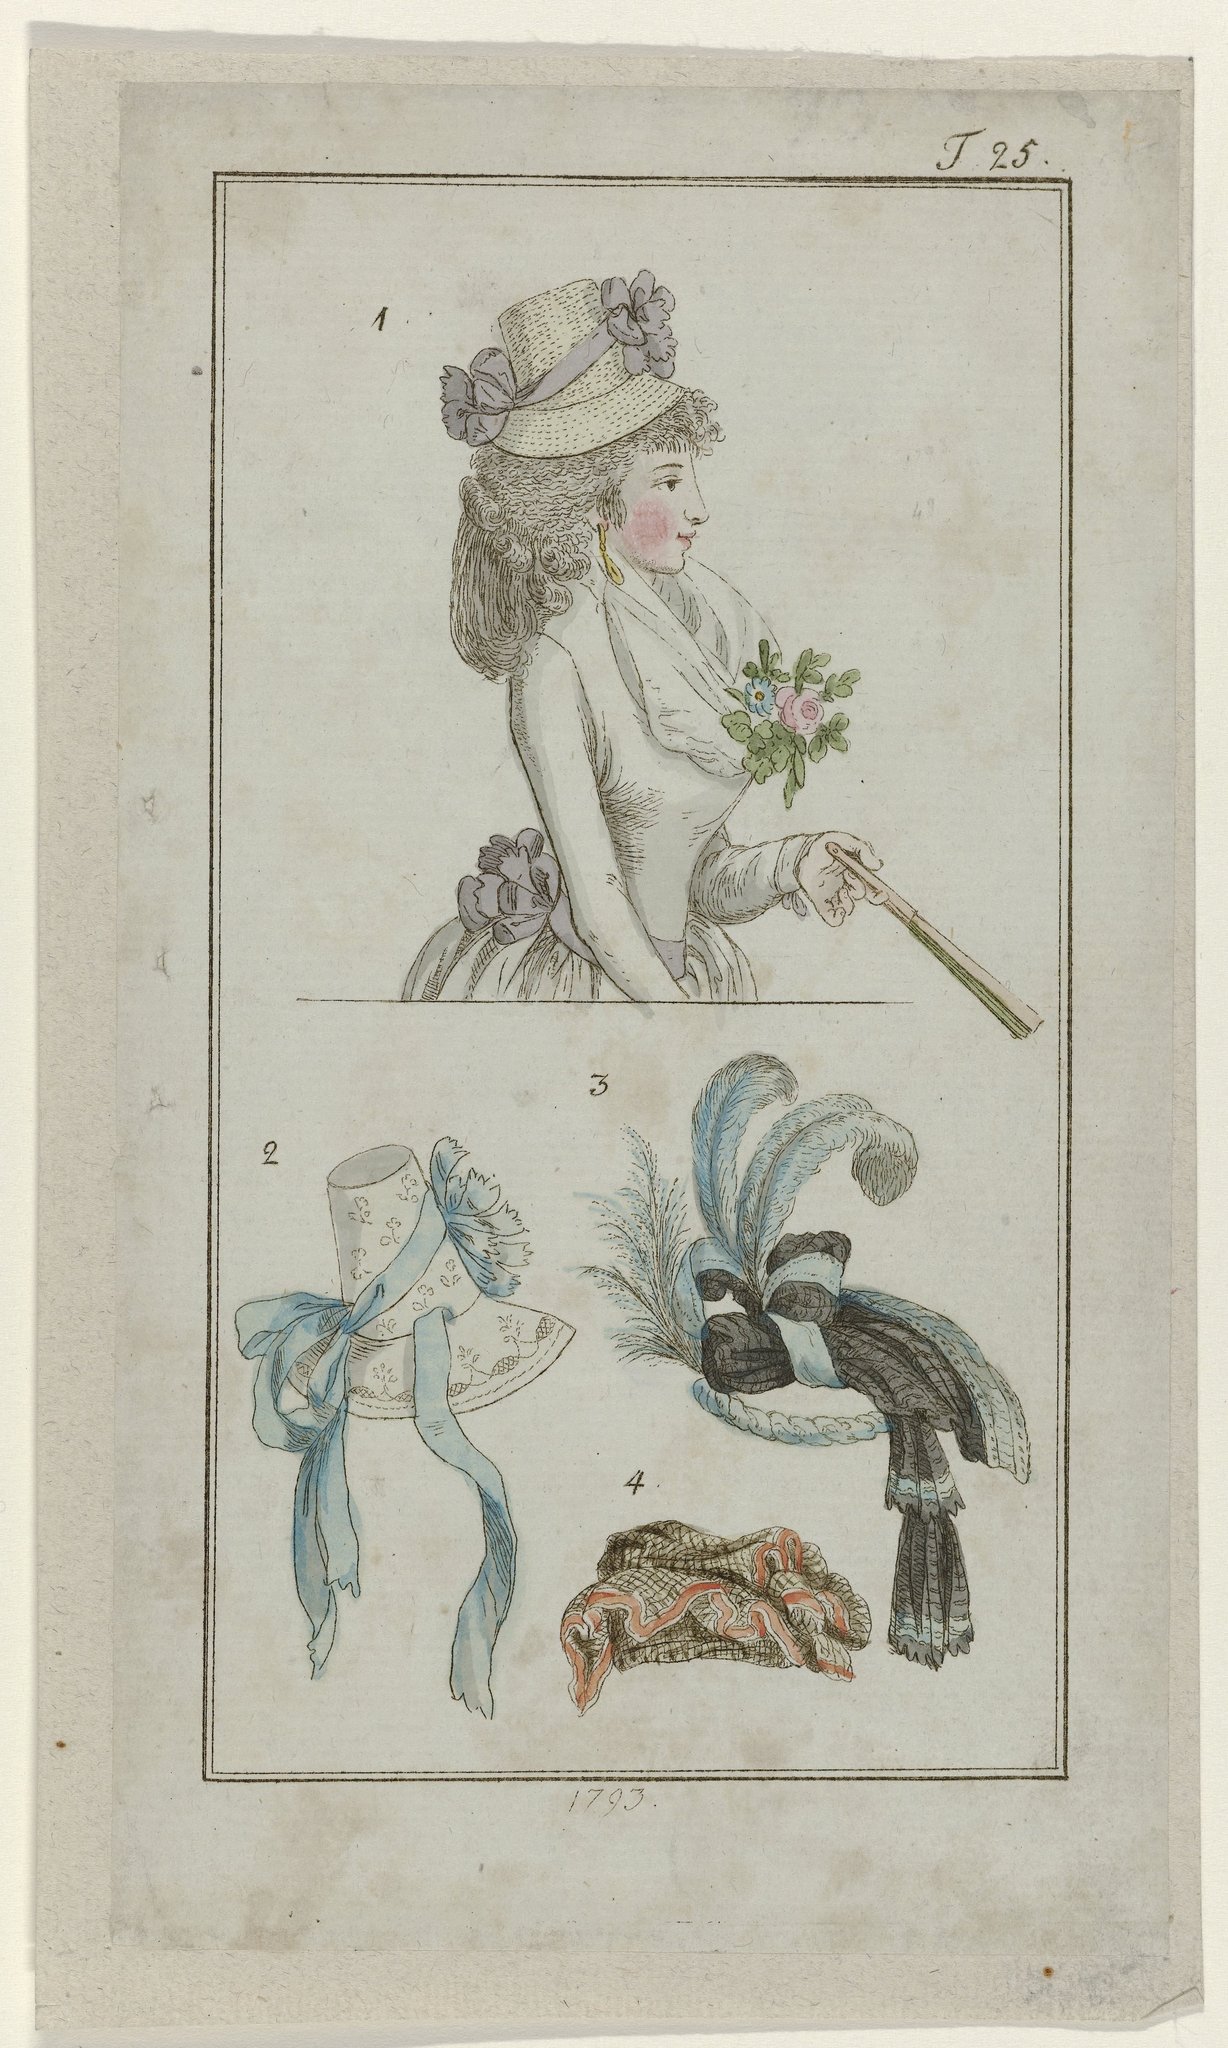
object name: fashion print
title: Journal des Luxus und der Moden, 1793, T 25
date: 1793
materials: paper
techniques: etching, hand coloring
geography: weimar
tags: corsage (+ women's clothes), ear-rings (+ women's clothes), cut flowers; nosegay, bunch of flowers, fashion plates, head-gear: hat (+ women's clothes), dress, gown (+ women's clothes), fan (+ women's clothes), piece of clothing covering the breast or décolleté (fichu) (+ women's clothes)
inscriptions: date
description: Nummer 1: vrouw, ten halven lijve, in een japon met lange mouwen. Accessoires: hoed versierd met linten, oorbel in het rechteroor, fichu, bloemcorsage, ceintuur, waaier. Aan de onderzijde drie verschillende hoofddeksels, genummerd 2 t/m 4. Prent uit het modetijdschrift Journal des Luxus und der Moden, uitgegeven door Friedrich Justin Bertuch en Georg Melchior Kraus, Weimar, 1786-1826.